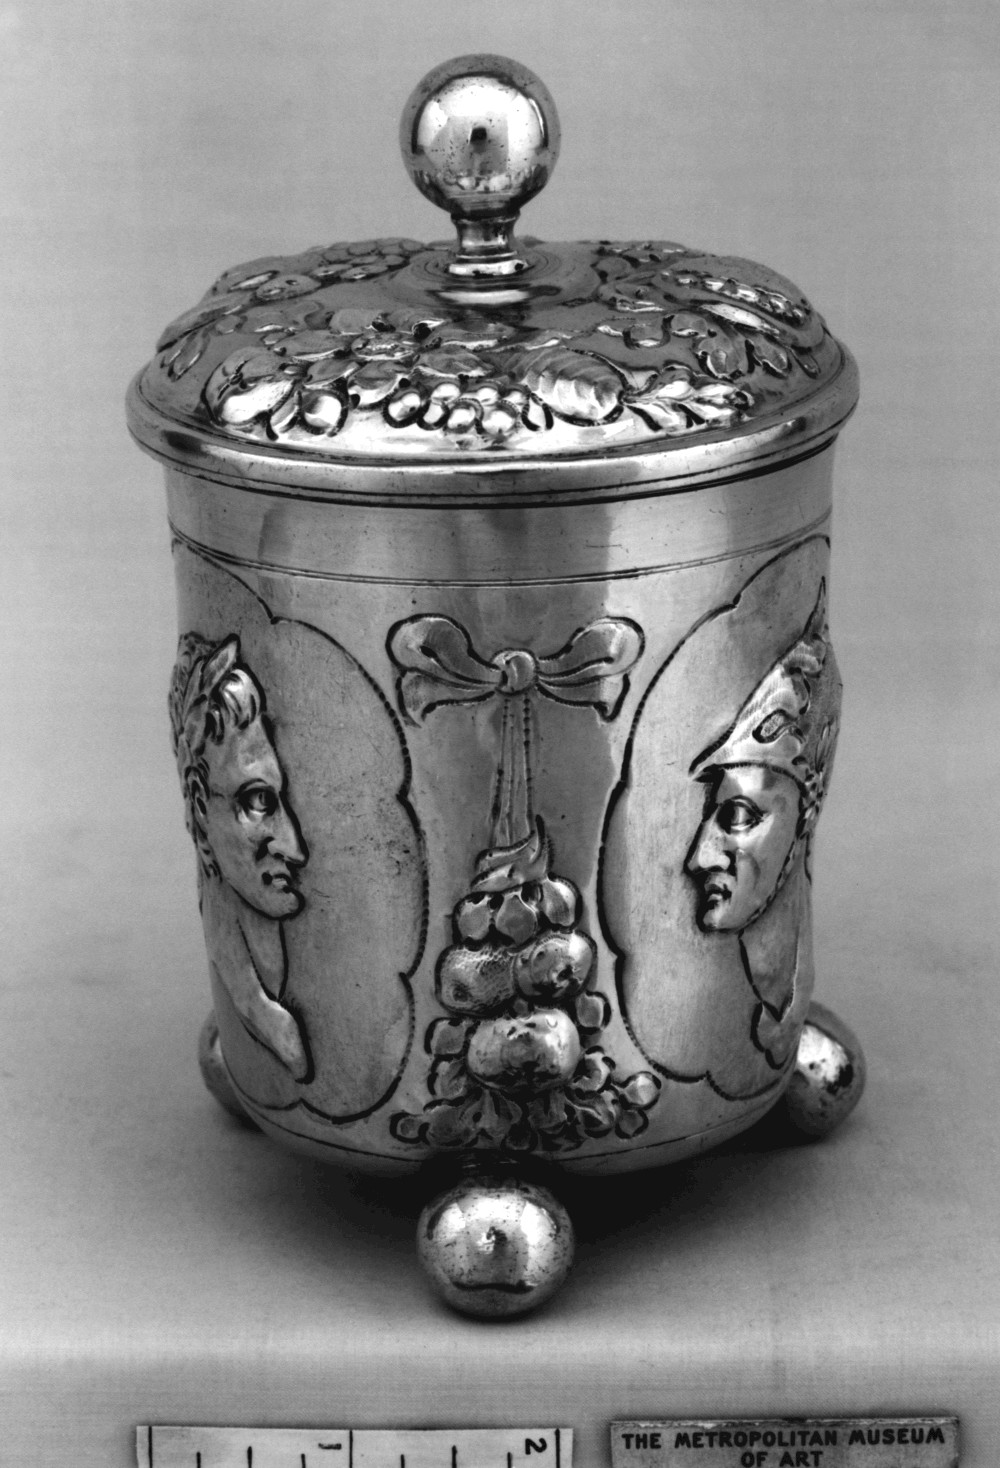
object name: beaker with cover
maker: johann christoph pfeiffelmann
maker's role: maker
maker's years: 1610-1710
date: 1695-1699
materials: gilt, silver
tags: men,profiles